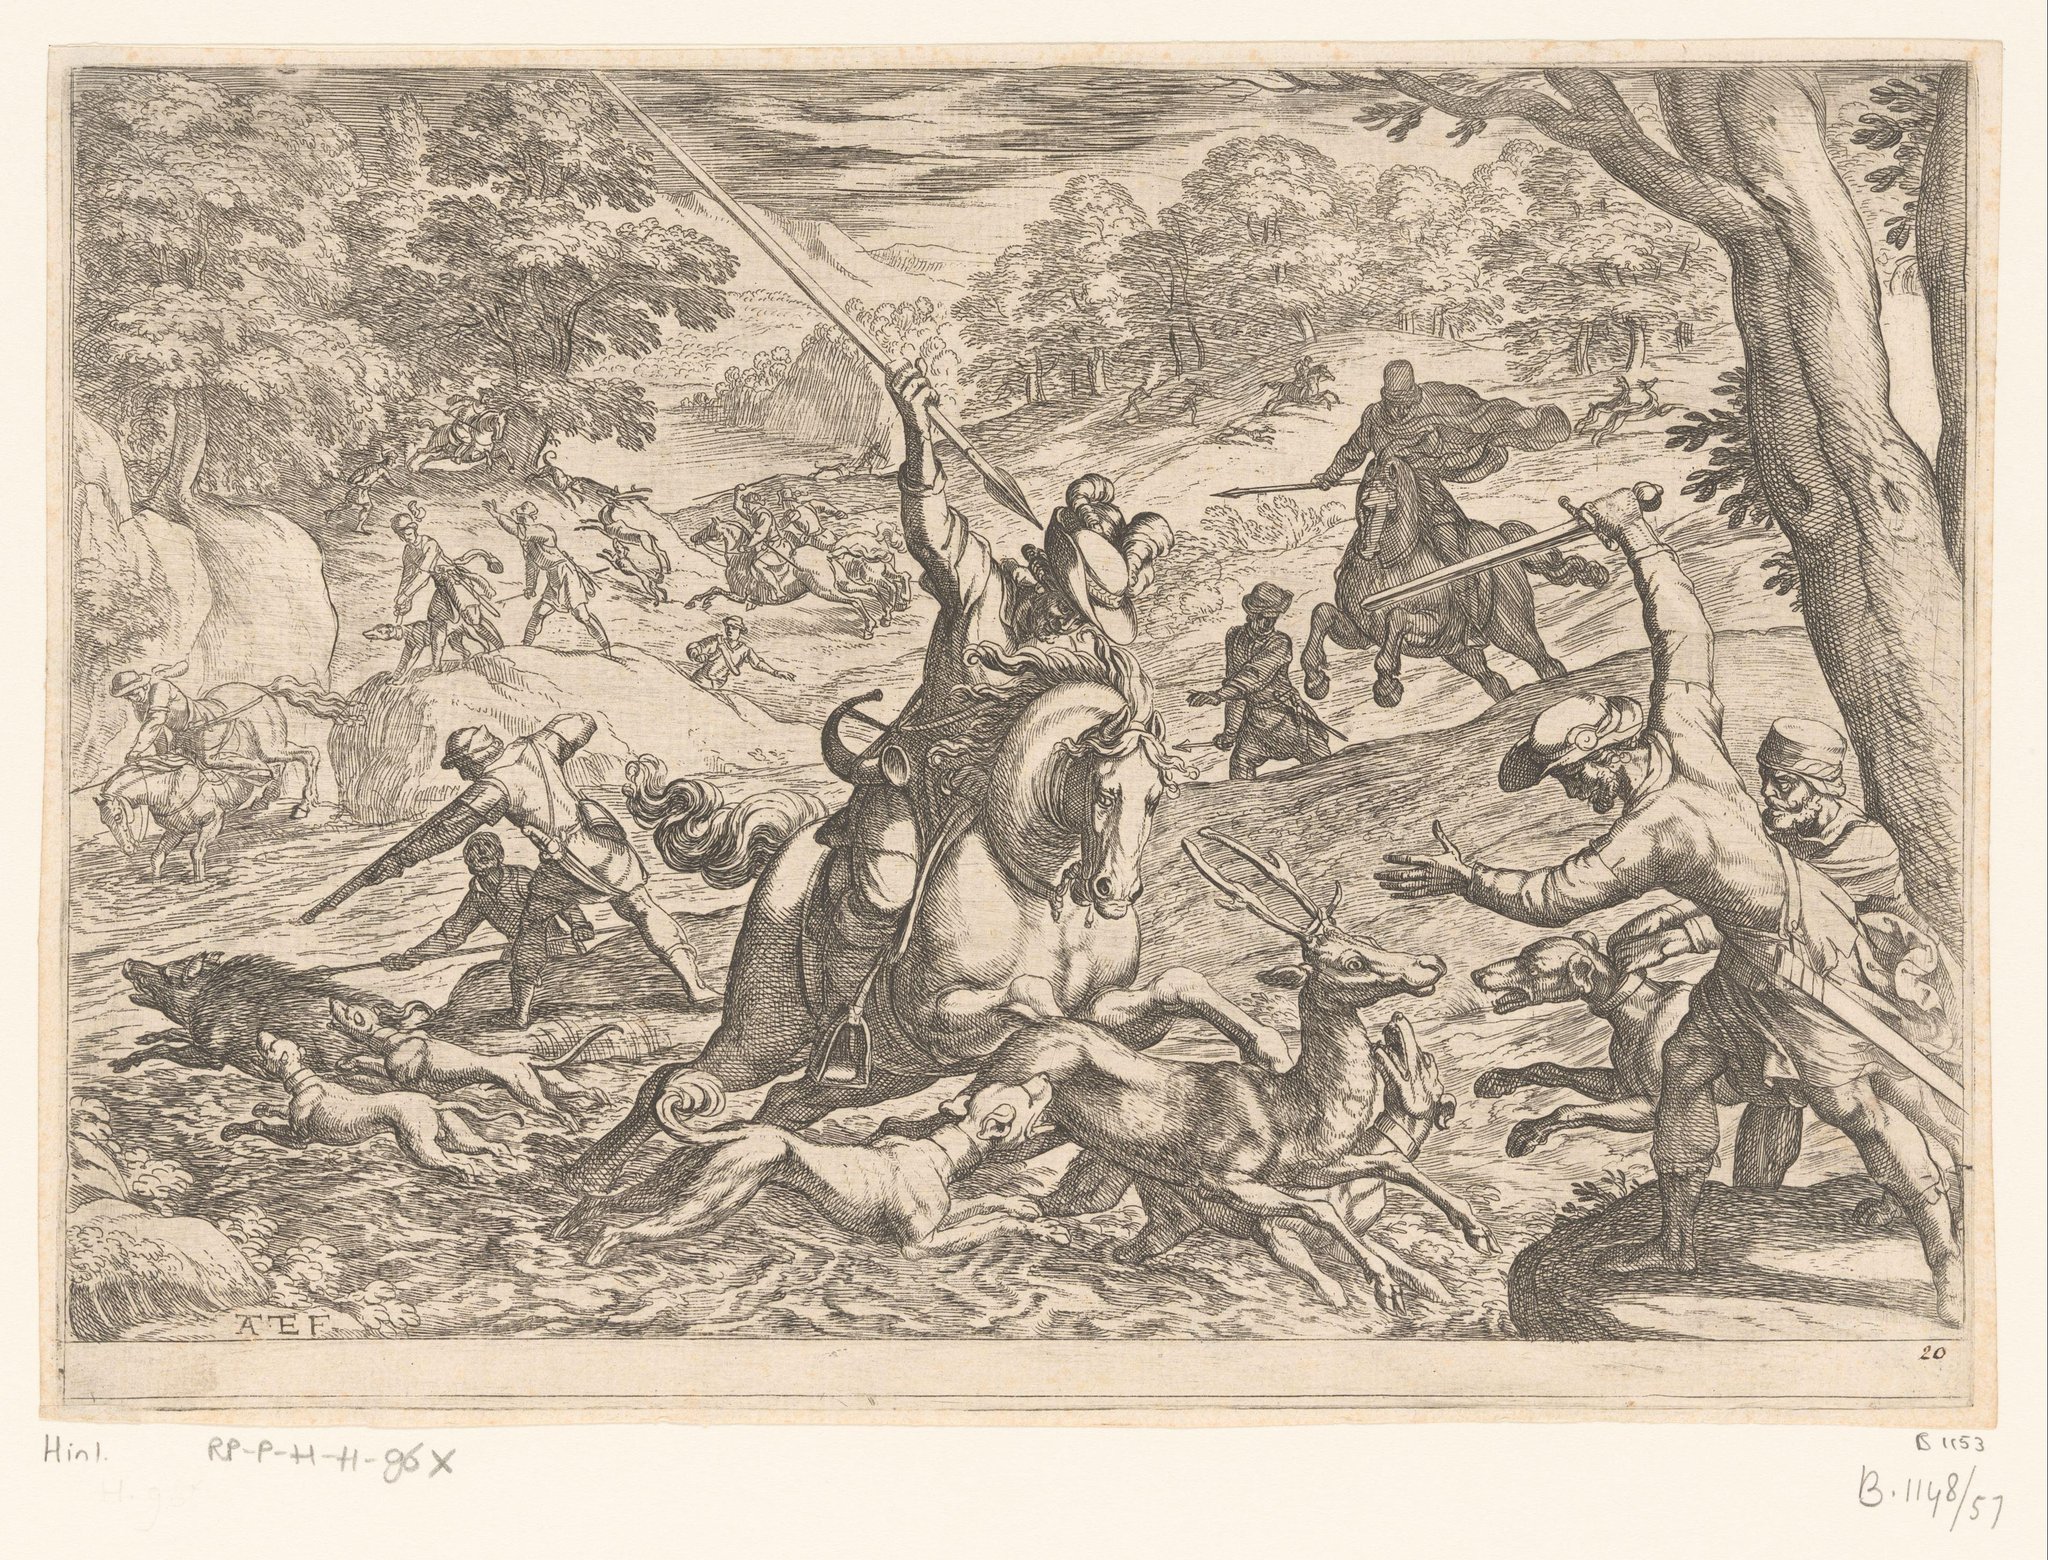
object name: print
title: Jachtscènes (deel 7)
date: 1608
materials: paper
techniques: etching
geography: rome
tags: stag-hunting, boar-hunting, hunter, hunters hunting (n.b.: in 1988-1990 this notation denoted the concept of 43c11421 'hunters resting during the hunt')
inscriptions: number: ‘20’, collector's mark: Lugt 11, collector's mark: ‘Hinloopen’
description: Deze prent maakt deel uit van een reeks van acht prenten (+ opdracht) met jachtscènes.